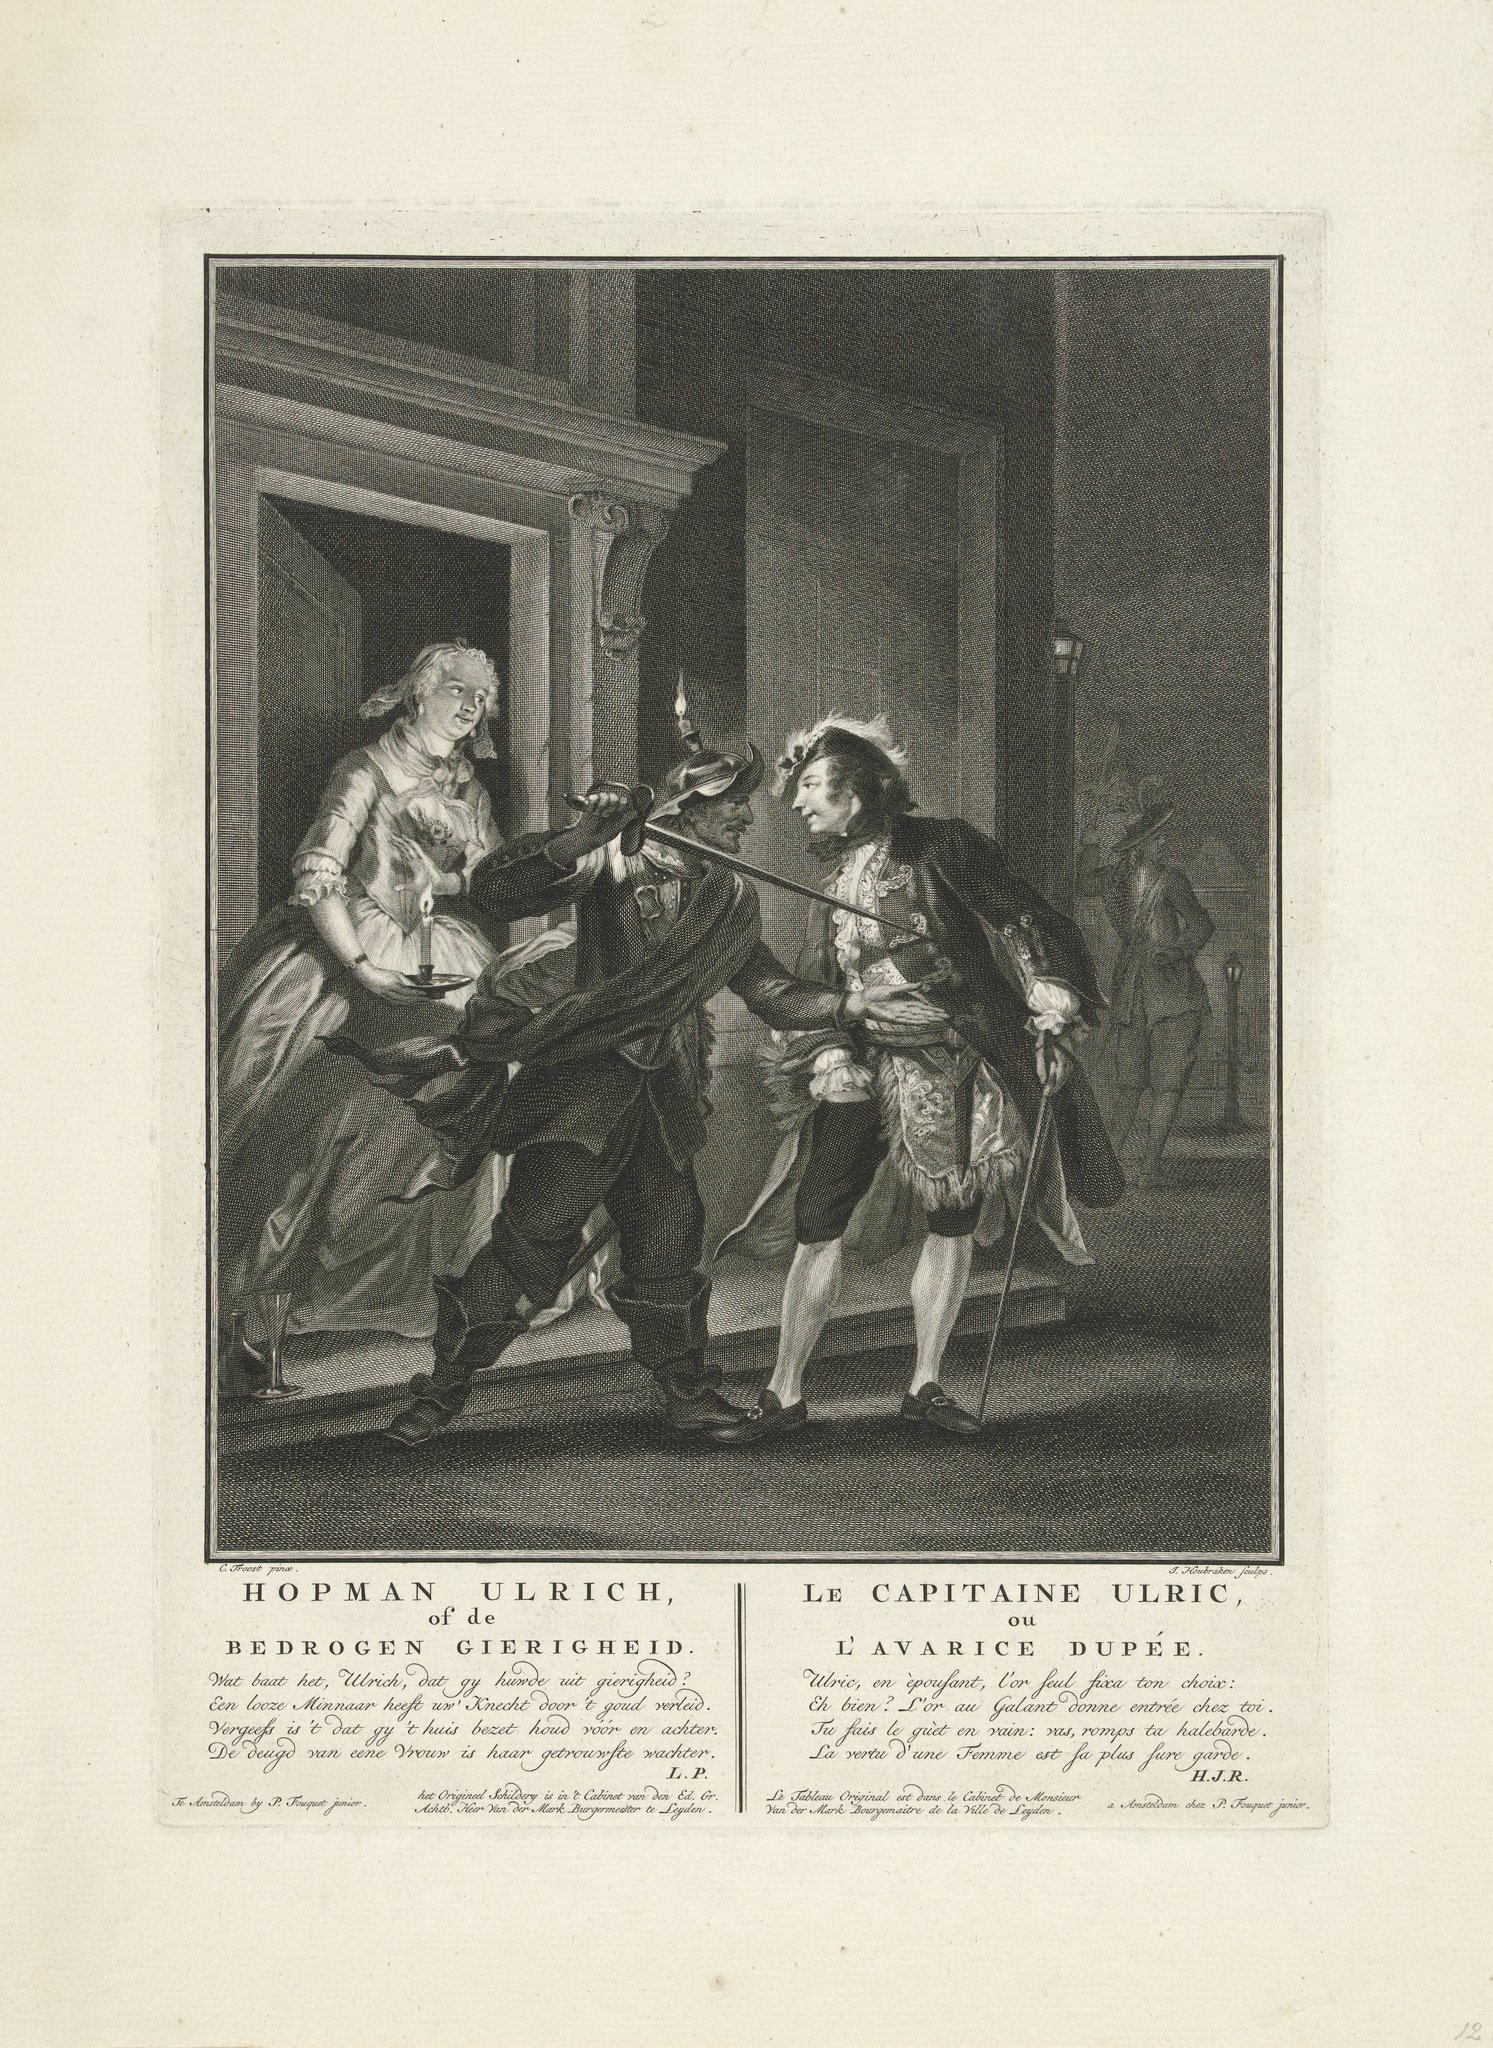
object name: print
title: Hopman Ulrich of de bedrogen gierigheid: de omkoping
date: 1760-1780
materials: paper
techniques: engraving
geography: amsterdam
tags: comedy, candlestick, guard duty, keeping sentry, night, bribery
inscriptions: collector's mark: Lugt 240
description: Een wachter met een zwaard vraagt een jongeman (Godefroy), die heimelijk in de nacht bij zijn geliefde (Sybille) op bezoek komt, om geld. De jongeman steekt zijn hand in zijn broekzak. De vrouw heeft een kaars vast. Op de stoep staan een glas en een fles. Rechts op de achtergrond een tweede wachter. Scène uit het blijspel 'Hopman Ulrich of de bedrogen gierigheid' van Johan van Paffenrode uit 1661, waarin het gierige personage Ulrich wordt bedrogen door zijn vrouw Sybille, ondanks dat hij haar laat bewaken. Haar minnaar Godefroy koopt de wachter om.